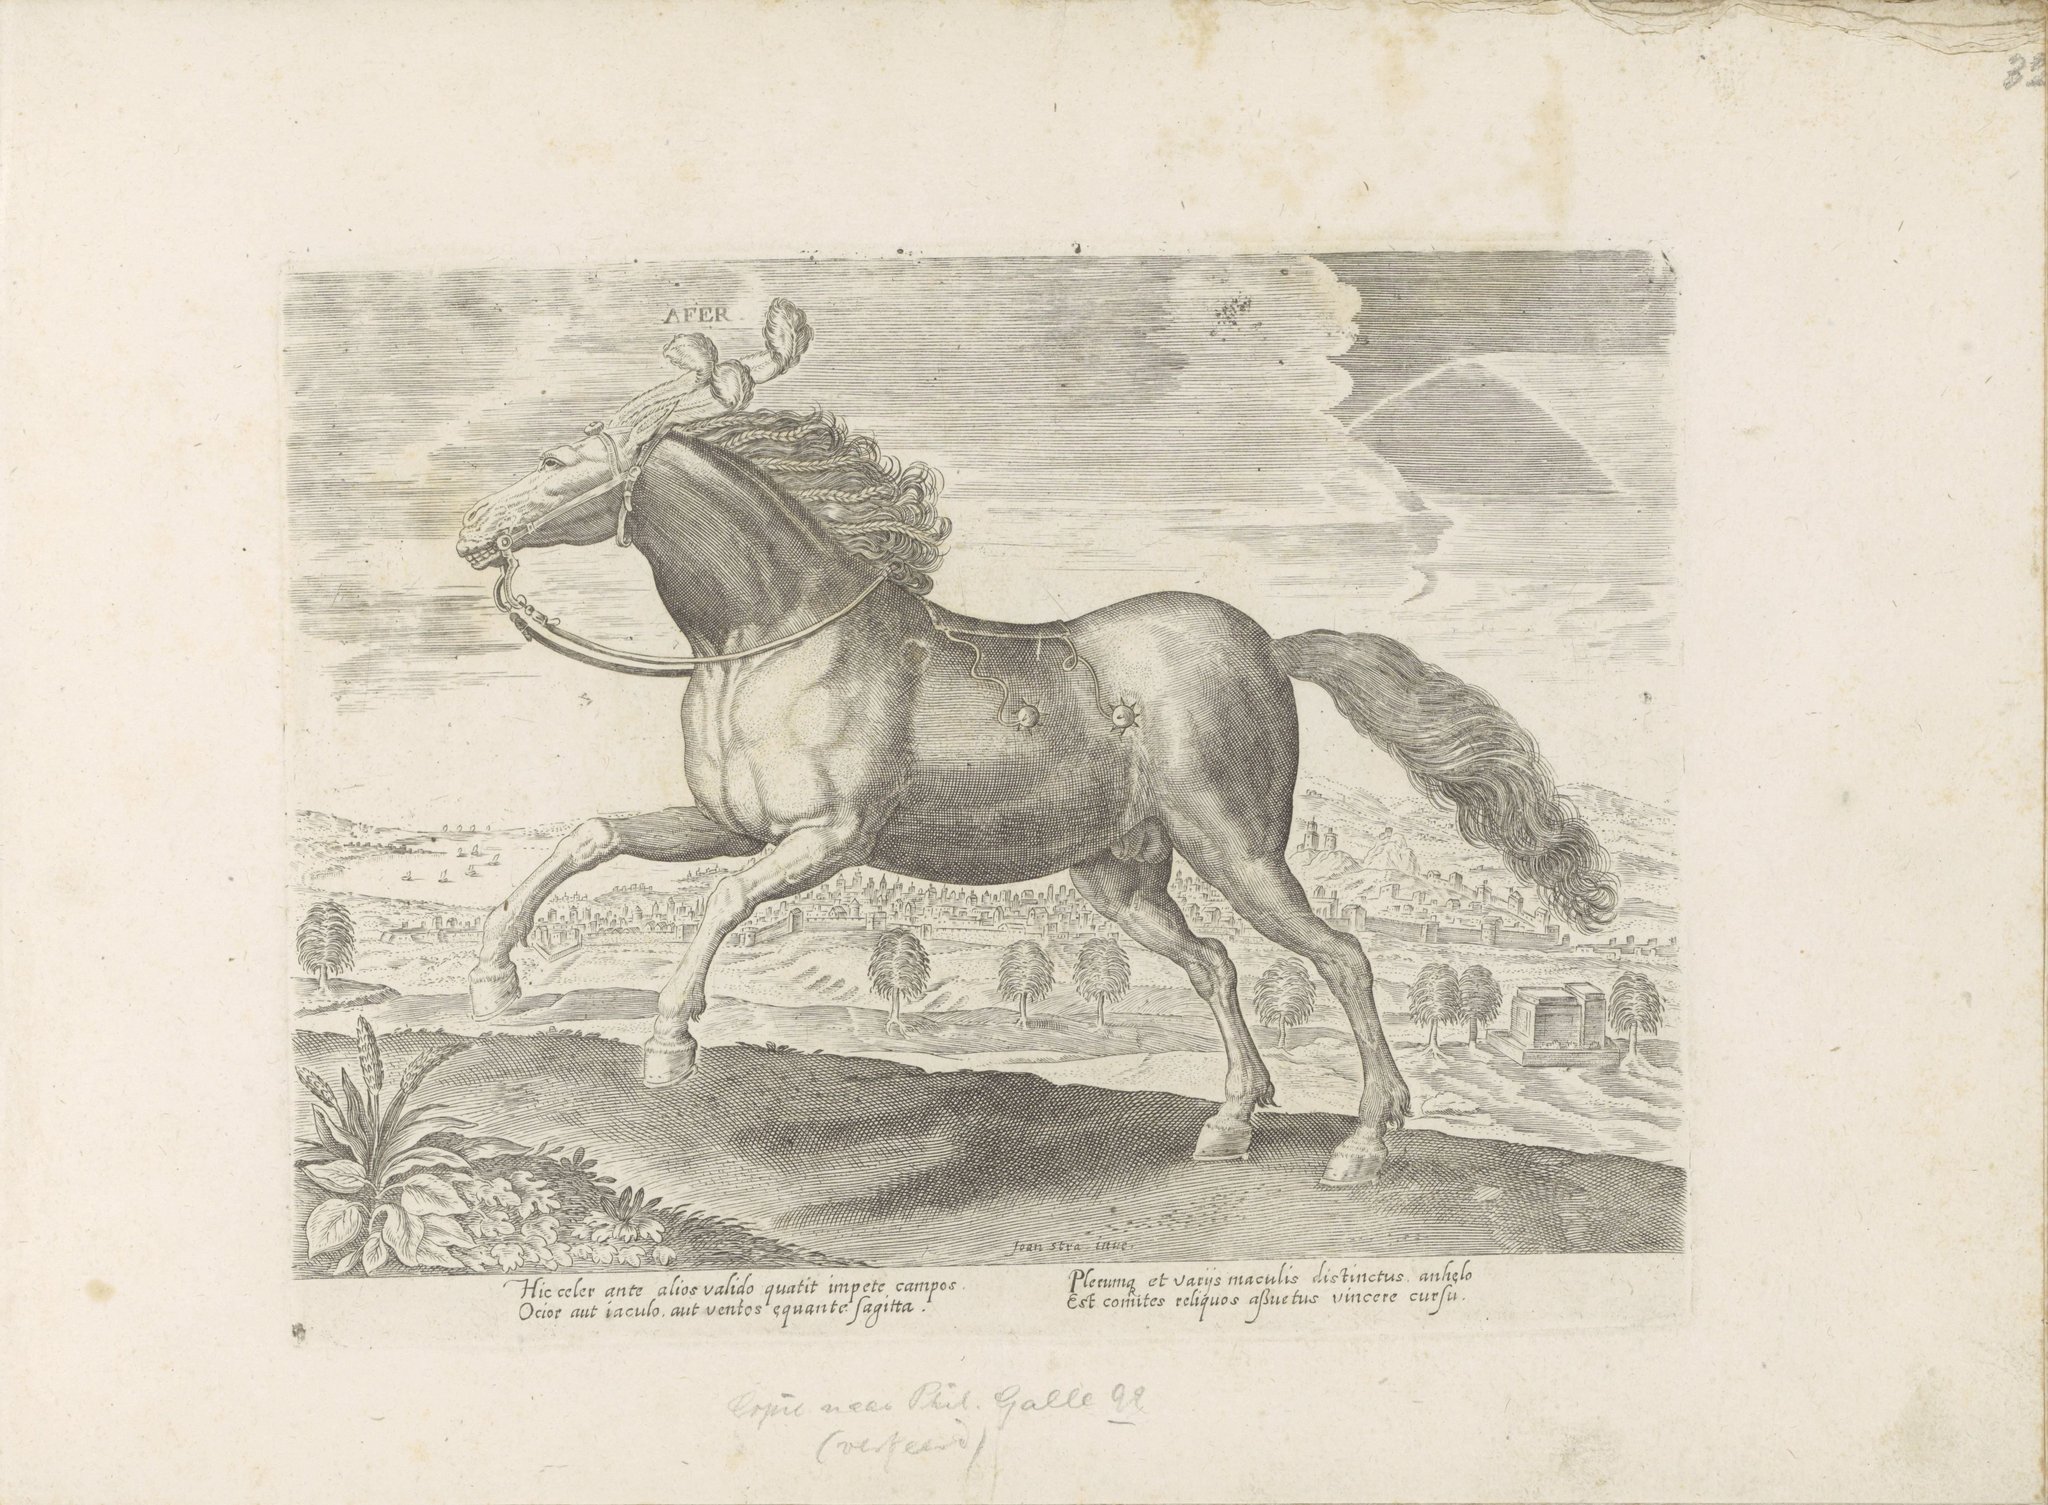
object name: print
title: Equile, in quo omnis generis generosissi: morum equorum ex varijs orbis partibus insignis delectus (...)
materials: paper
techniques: engraving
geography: venice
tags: don juan van oostenrijk, horses and kindred animals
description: Een Arabische hengst in een landschap. Prent maakt deel uit van een album.